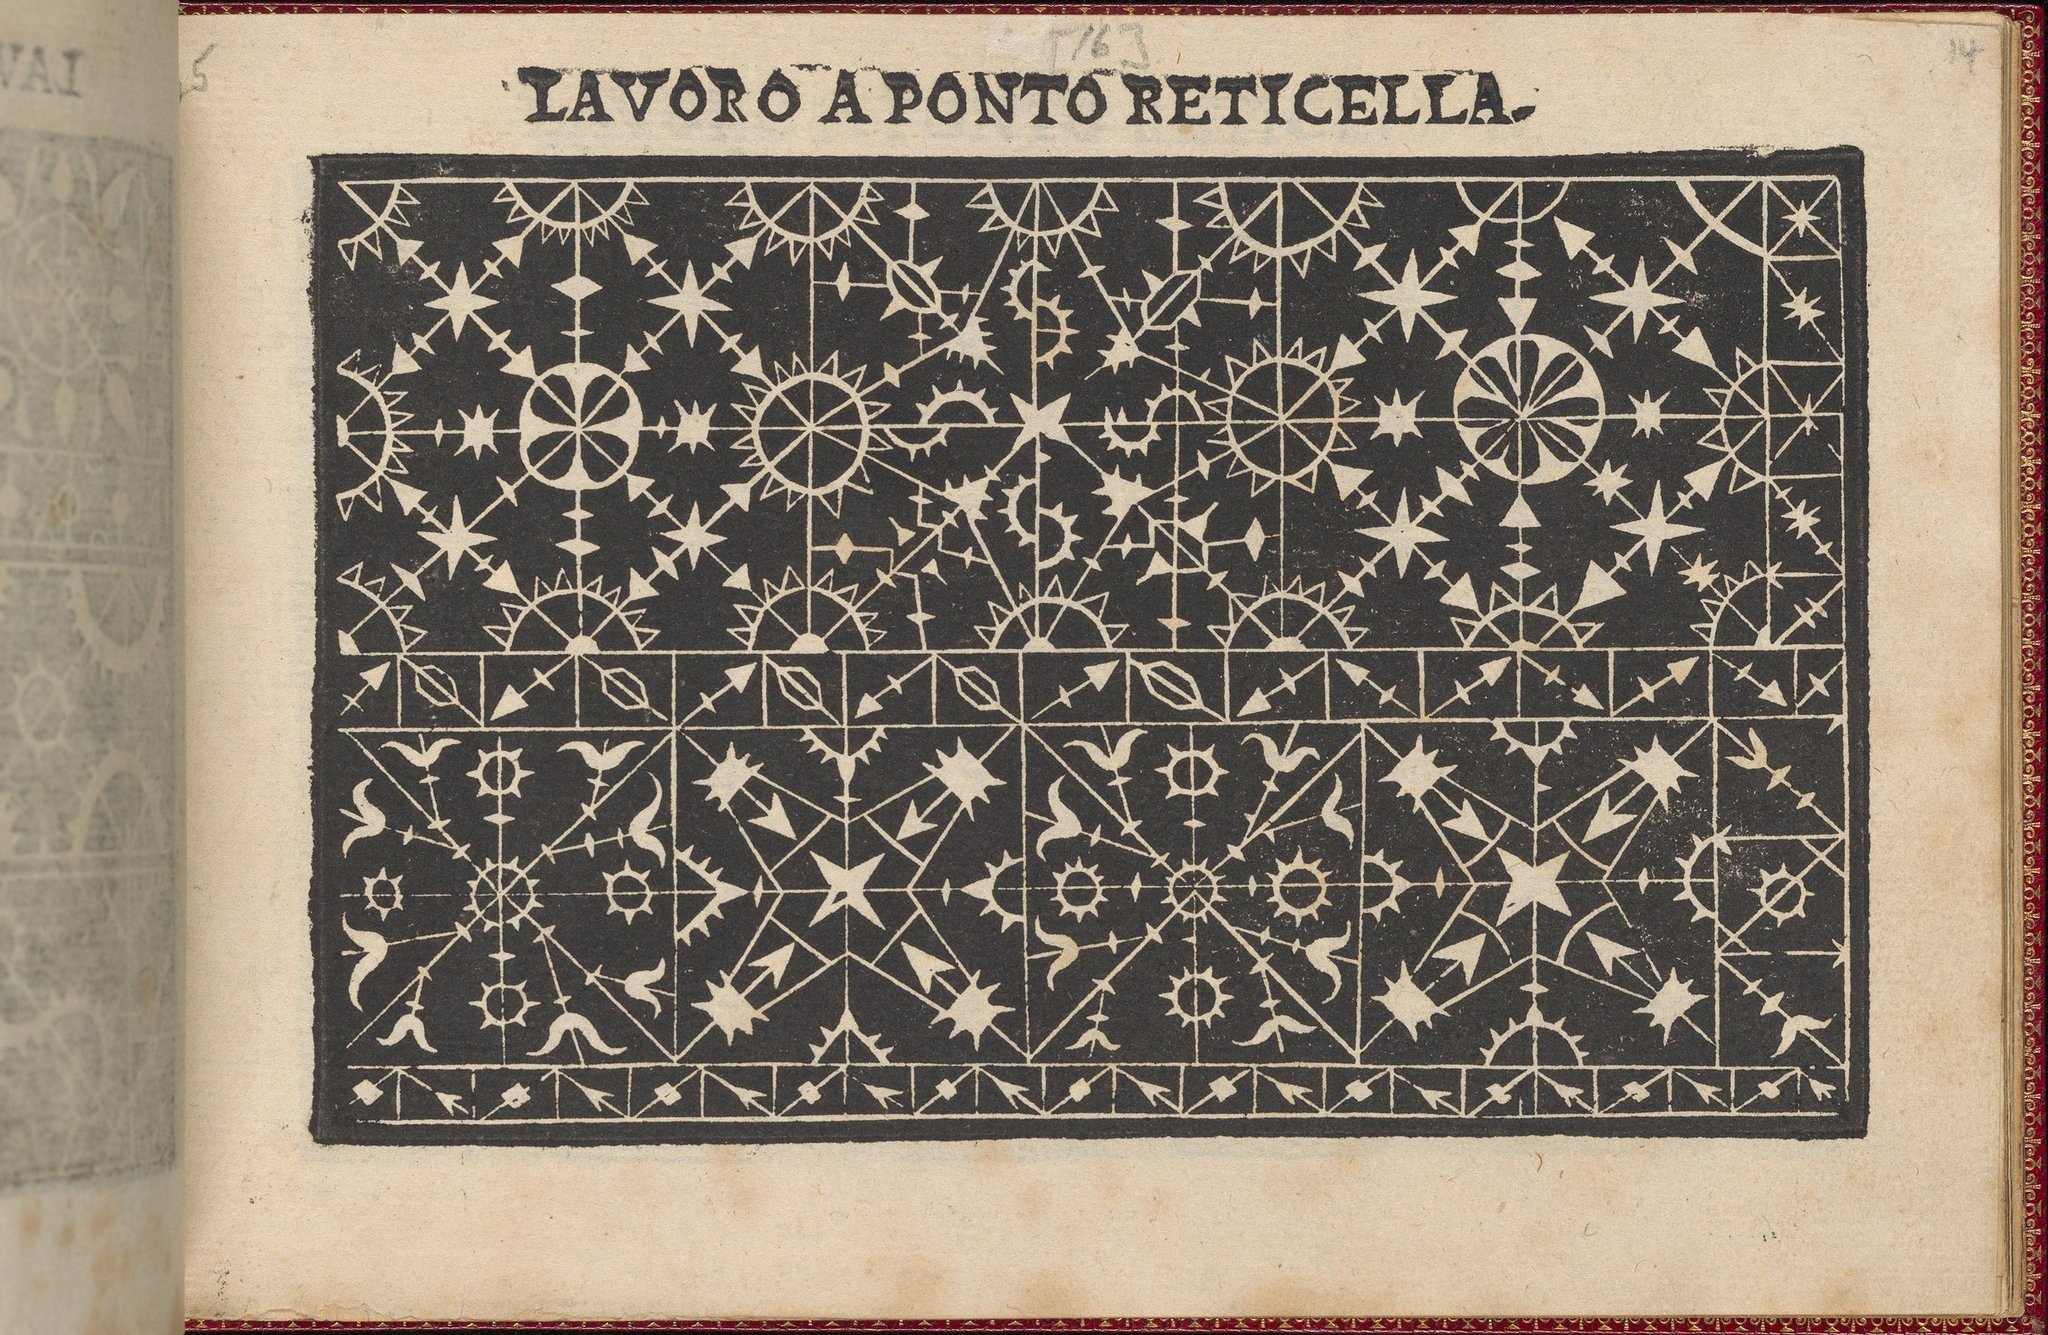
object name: book print ornament architecture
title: Pretiosa Gemma delle virtuose donne, page 16 (recto)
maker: isabella catanea parasole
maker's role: author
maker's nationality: italian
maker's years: 1565-1625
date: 1600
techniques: woodcut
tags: ornament